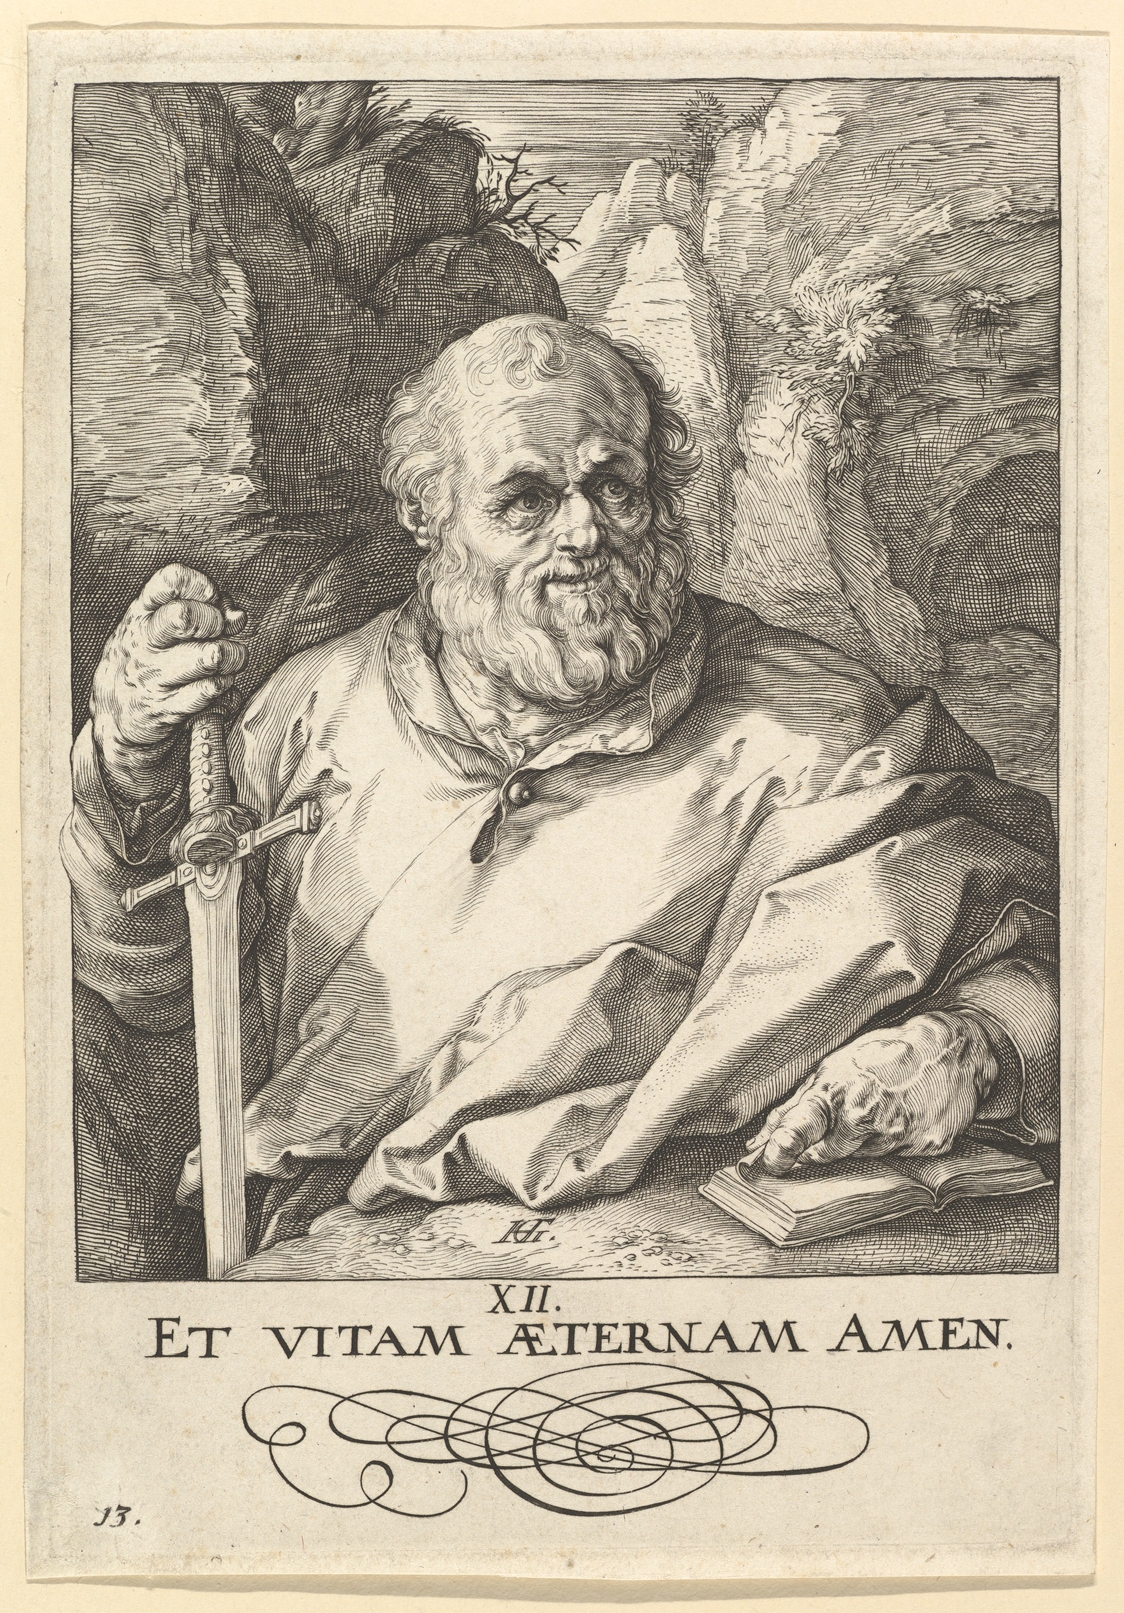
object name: print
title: St. Matthias, from "Christ, the Apostles and St. Paul with the Creed"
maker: hendrick goltzius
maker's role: artist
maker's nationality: netherlandish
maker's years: 1558-1617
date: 1589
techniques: engraving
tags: swords,men,saints